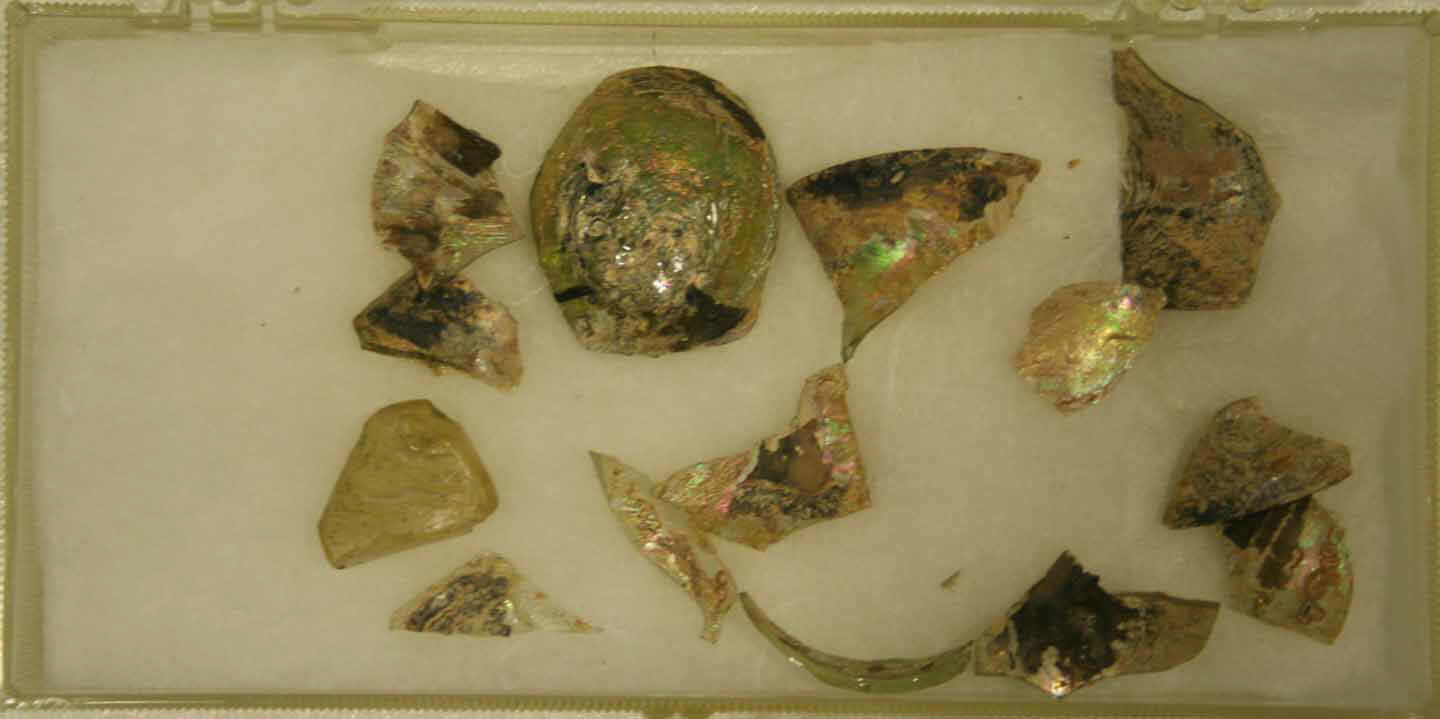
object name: bottle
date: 901-1100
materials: glass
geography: iran